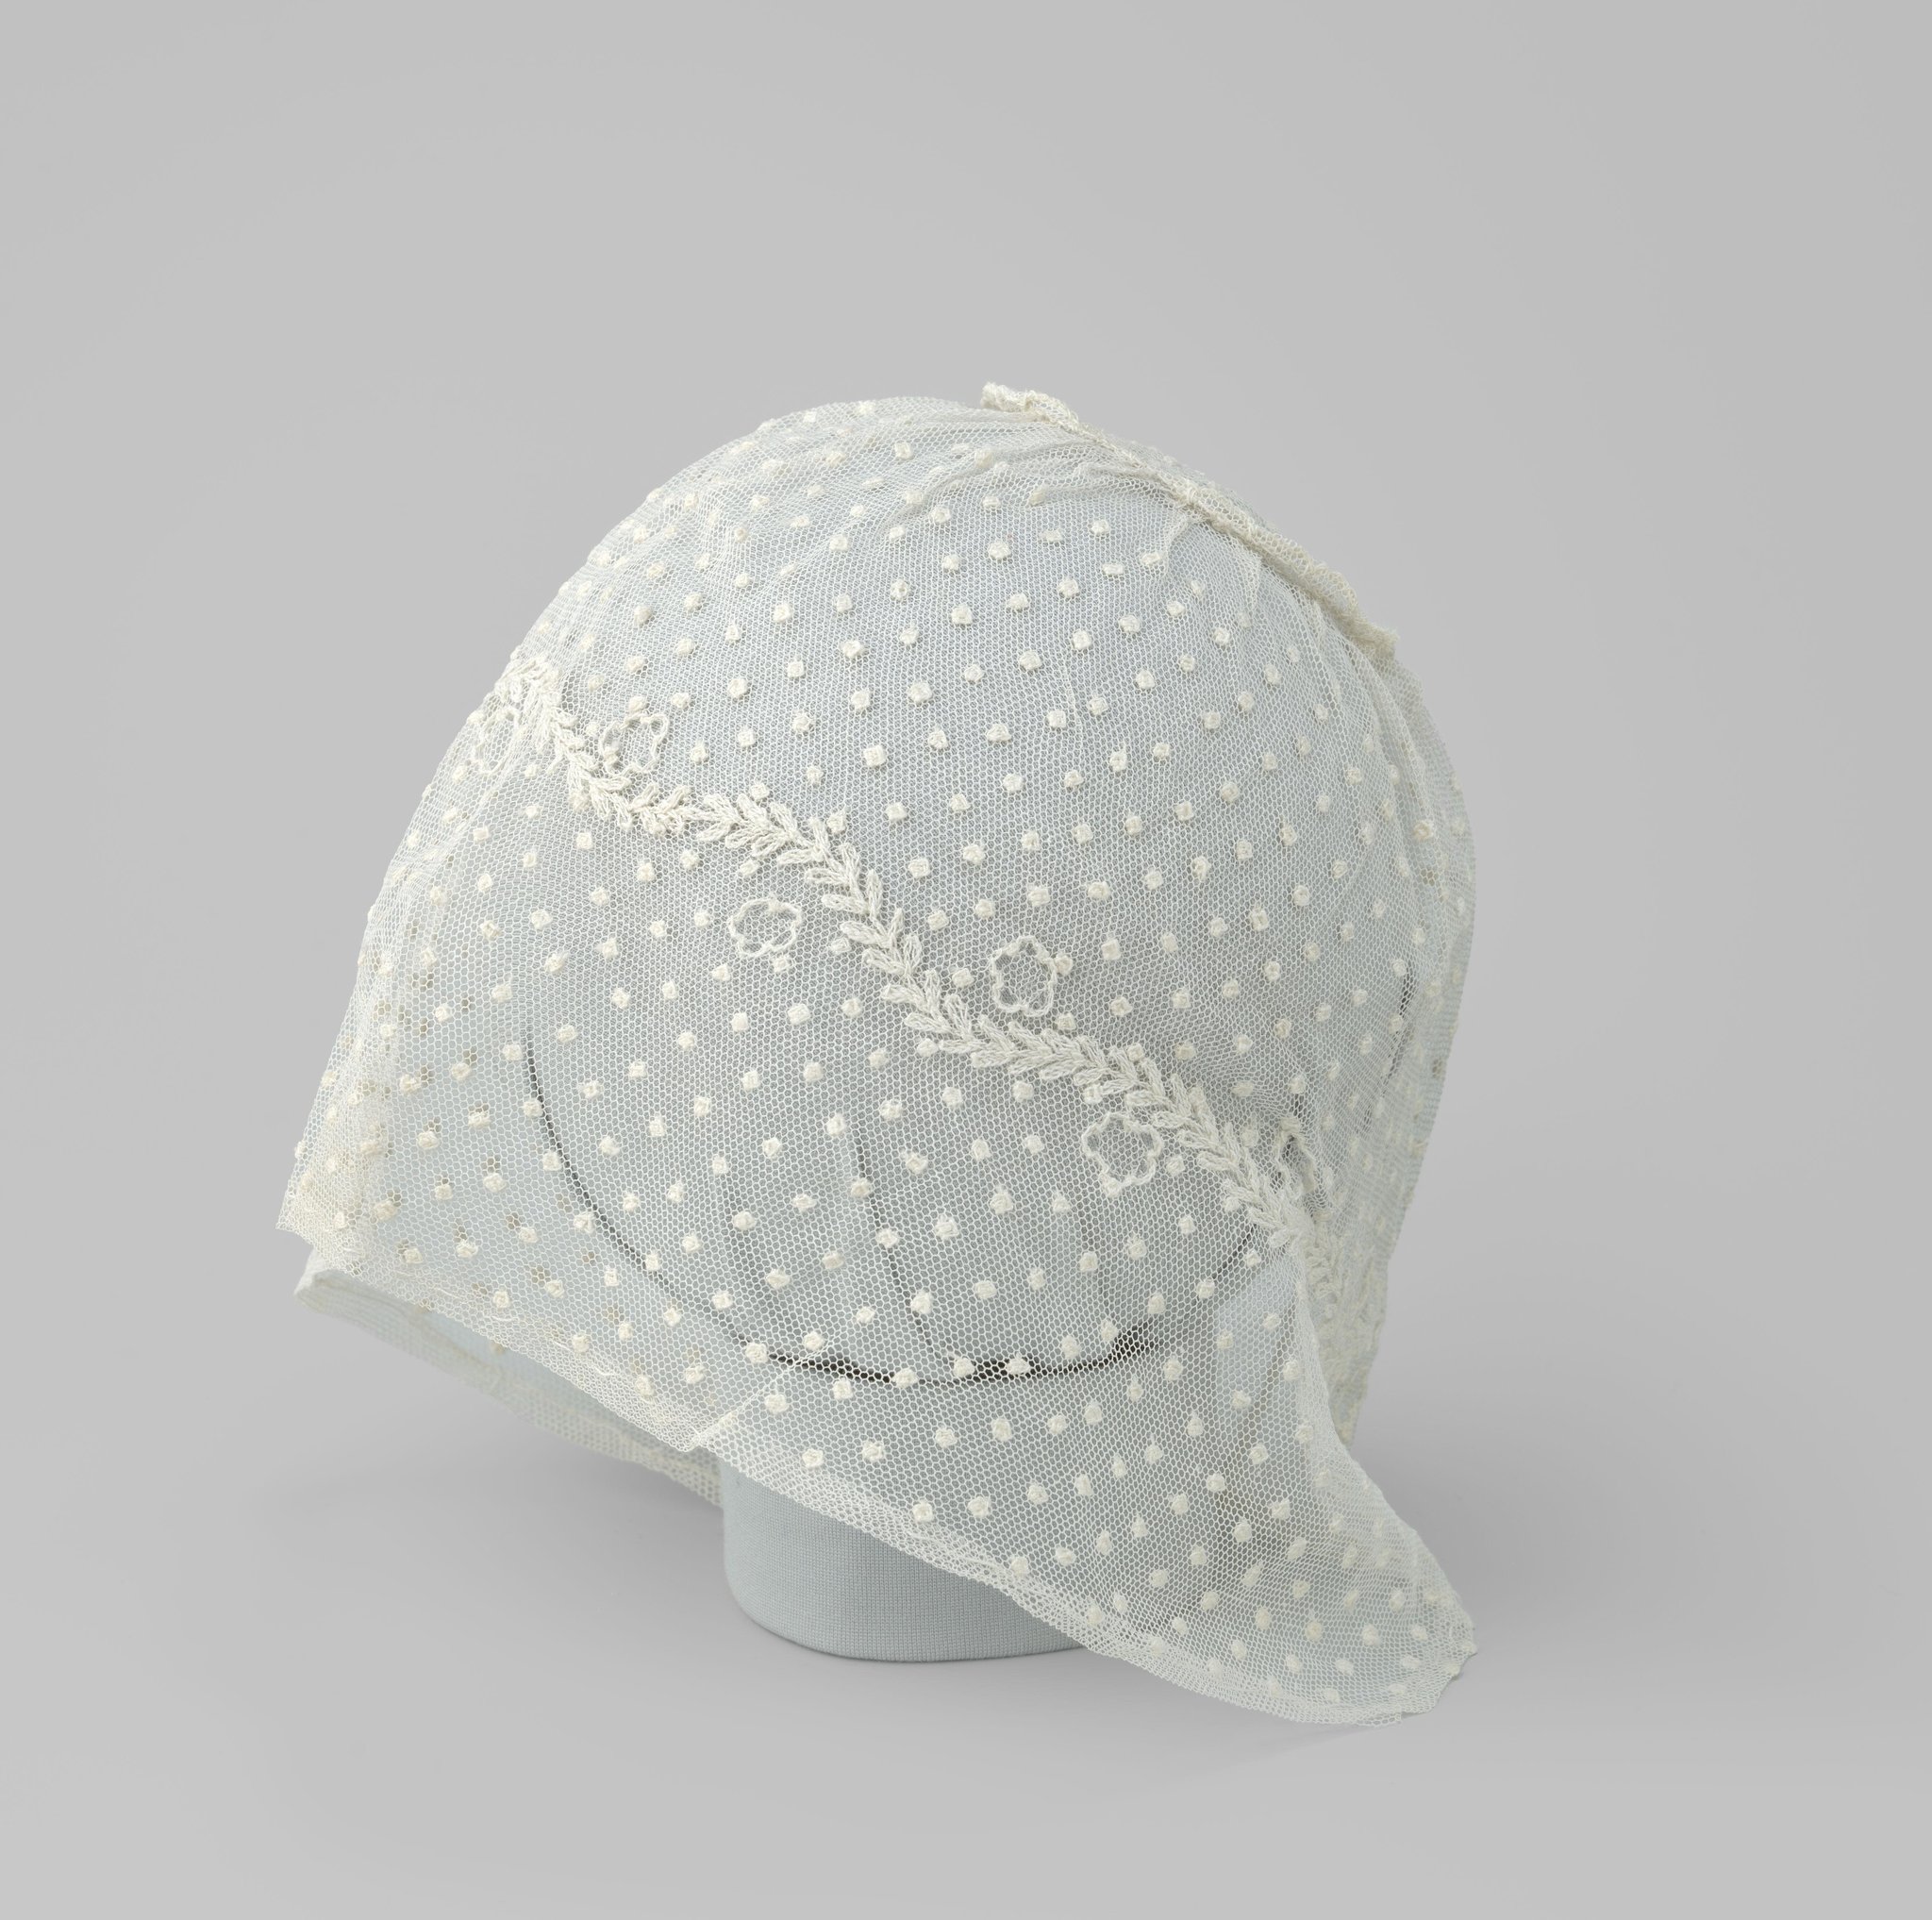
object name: cap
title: Muts van witte tule met moesjes en doorlopende geborduurde tak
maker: Anonymous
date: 1800-1900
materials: lace, fiber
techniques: embroidered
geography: netherlands